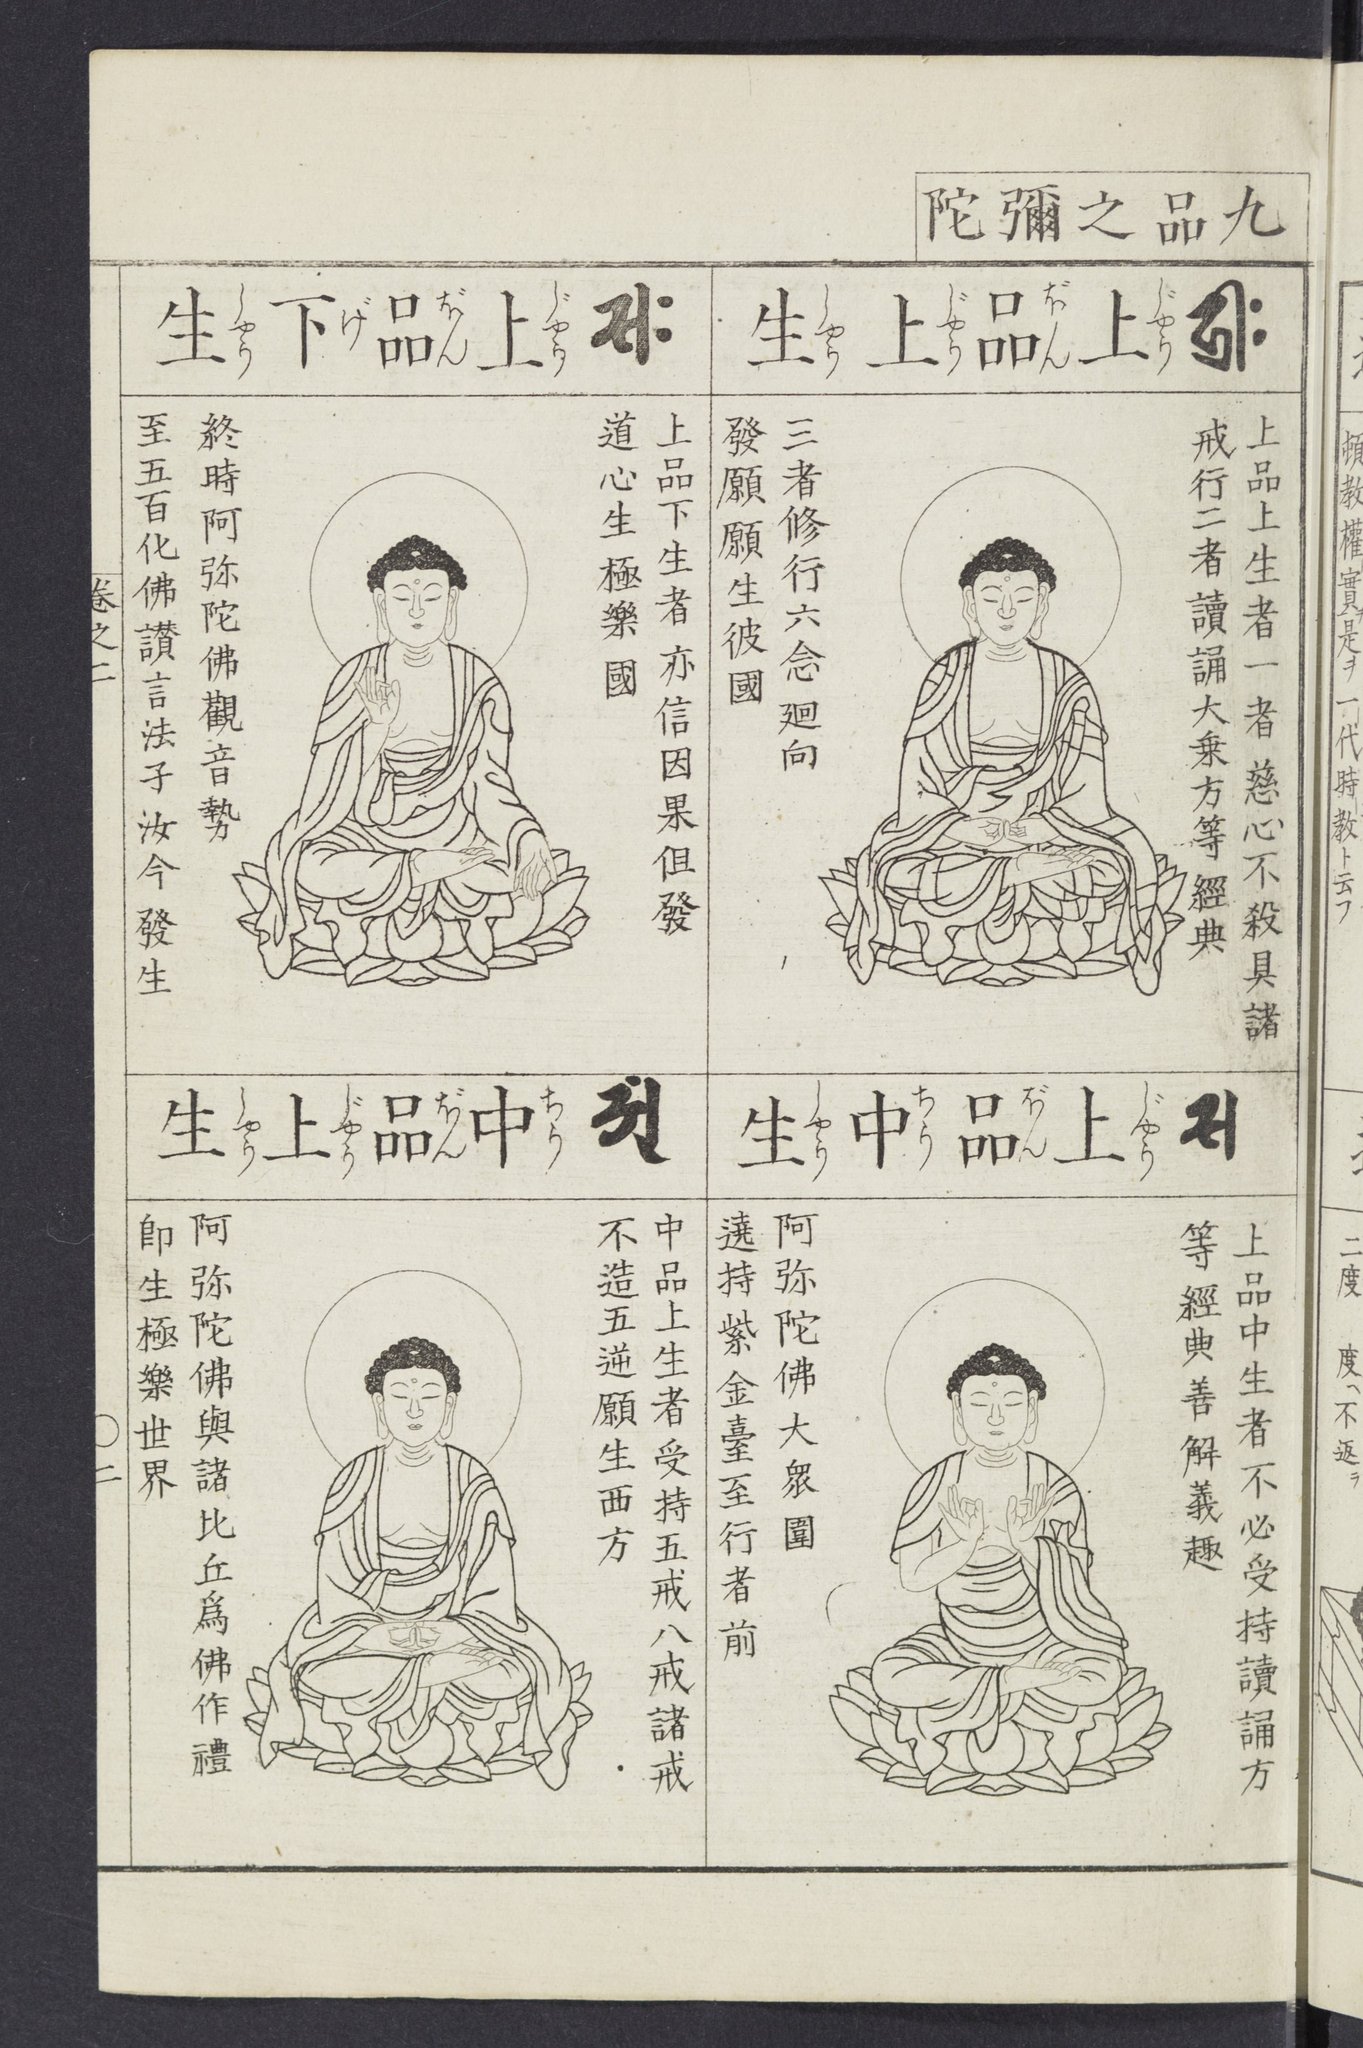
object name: illustrated book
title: Buddhist Figures and Their Attributes [Meiji edition] (Meiji zōho shoshū butsuzō zui) 明治増補諸宗佛像図彙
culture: japanese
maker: kino shūshin 紀秀信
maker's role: artist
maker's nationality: japanese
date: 1850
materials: ink, paper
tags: buddhism